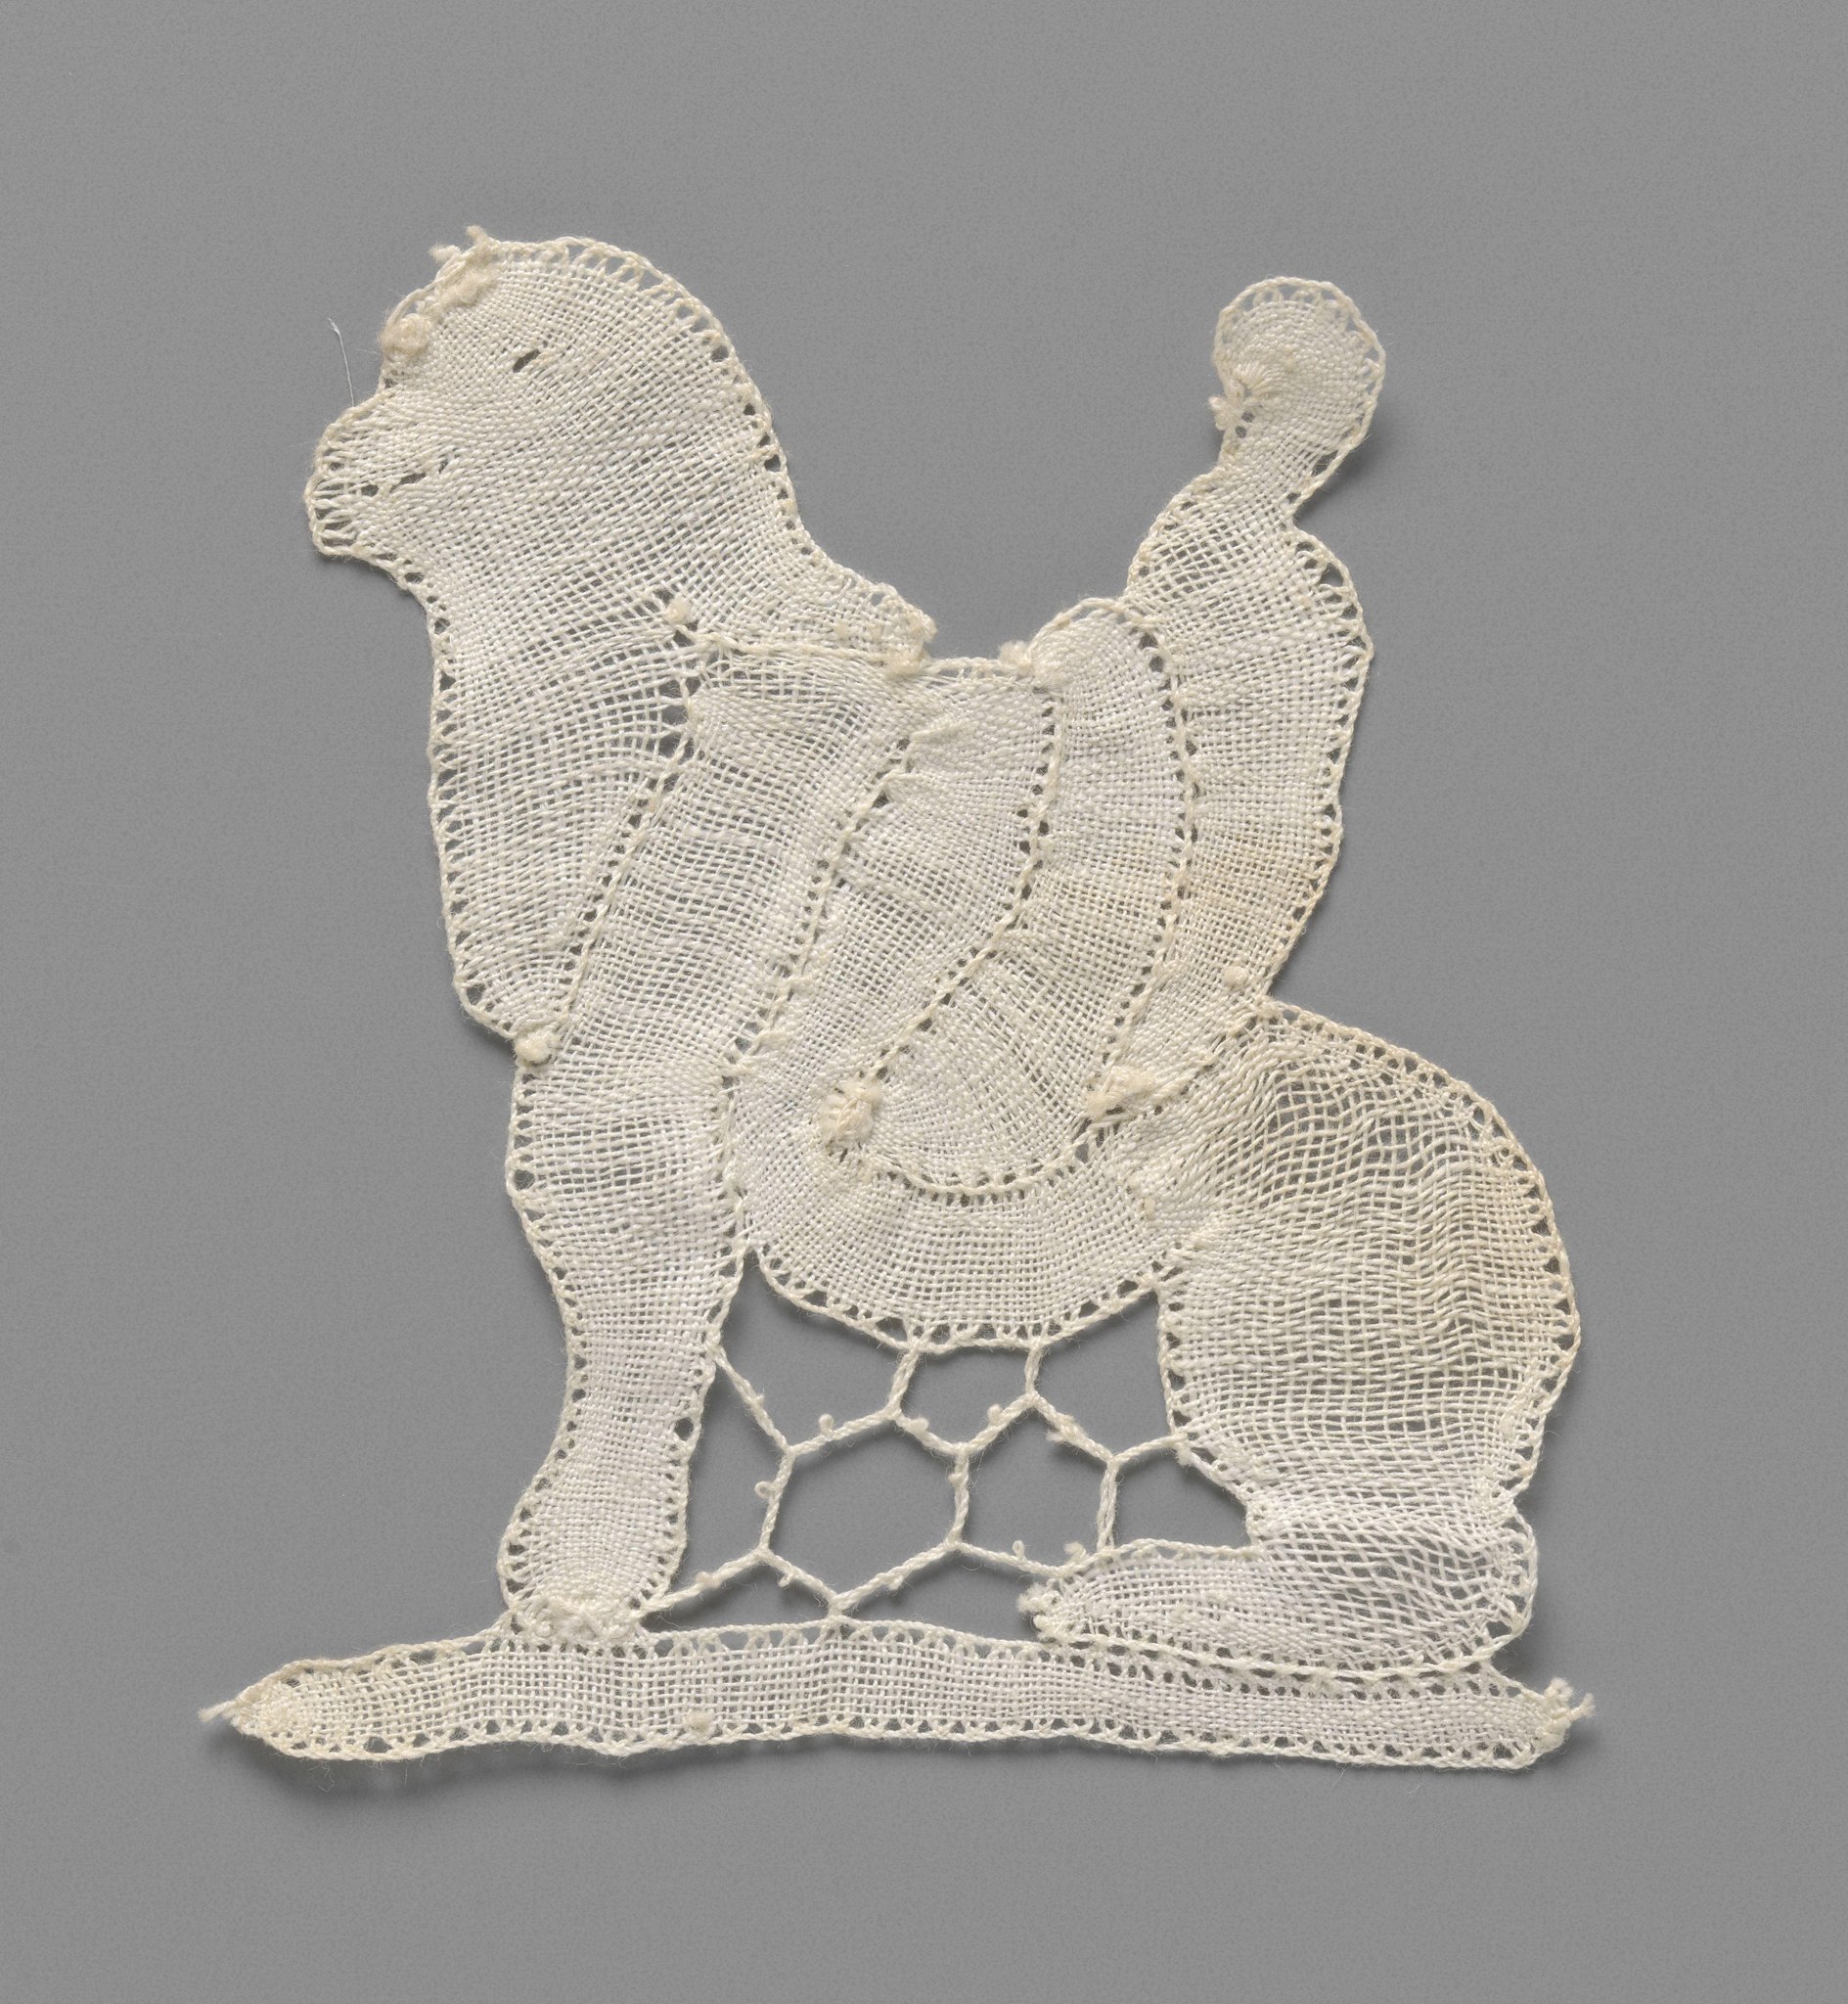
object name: motif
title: Motief van kloskant met de leeuw van Sint Marcus van Venetië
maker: Anonymous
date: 1914-1915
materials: cotton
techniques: lace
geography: belgium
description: Motief van naturelkleurig kloskant: war lace. Het motief stelt de leeuw van Sint Marcus van Venetië voor. Het is gemaakt met verschillende delen in linnenslag met opengewerkte randjes. Tussen de poten is een grove zeshoekige tralie met picots toegepast.